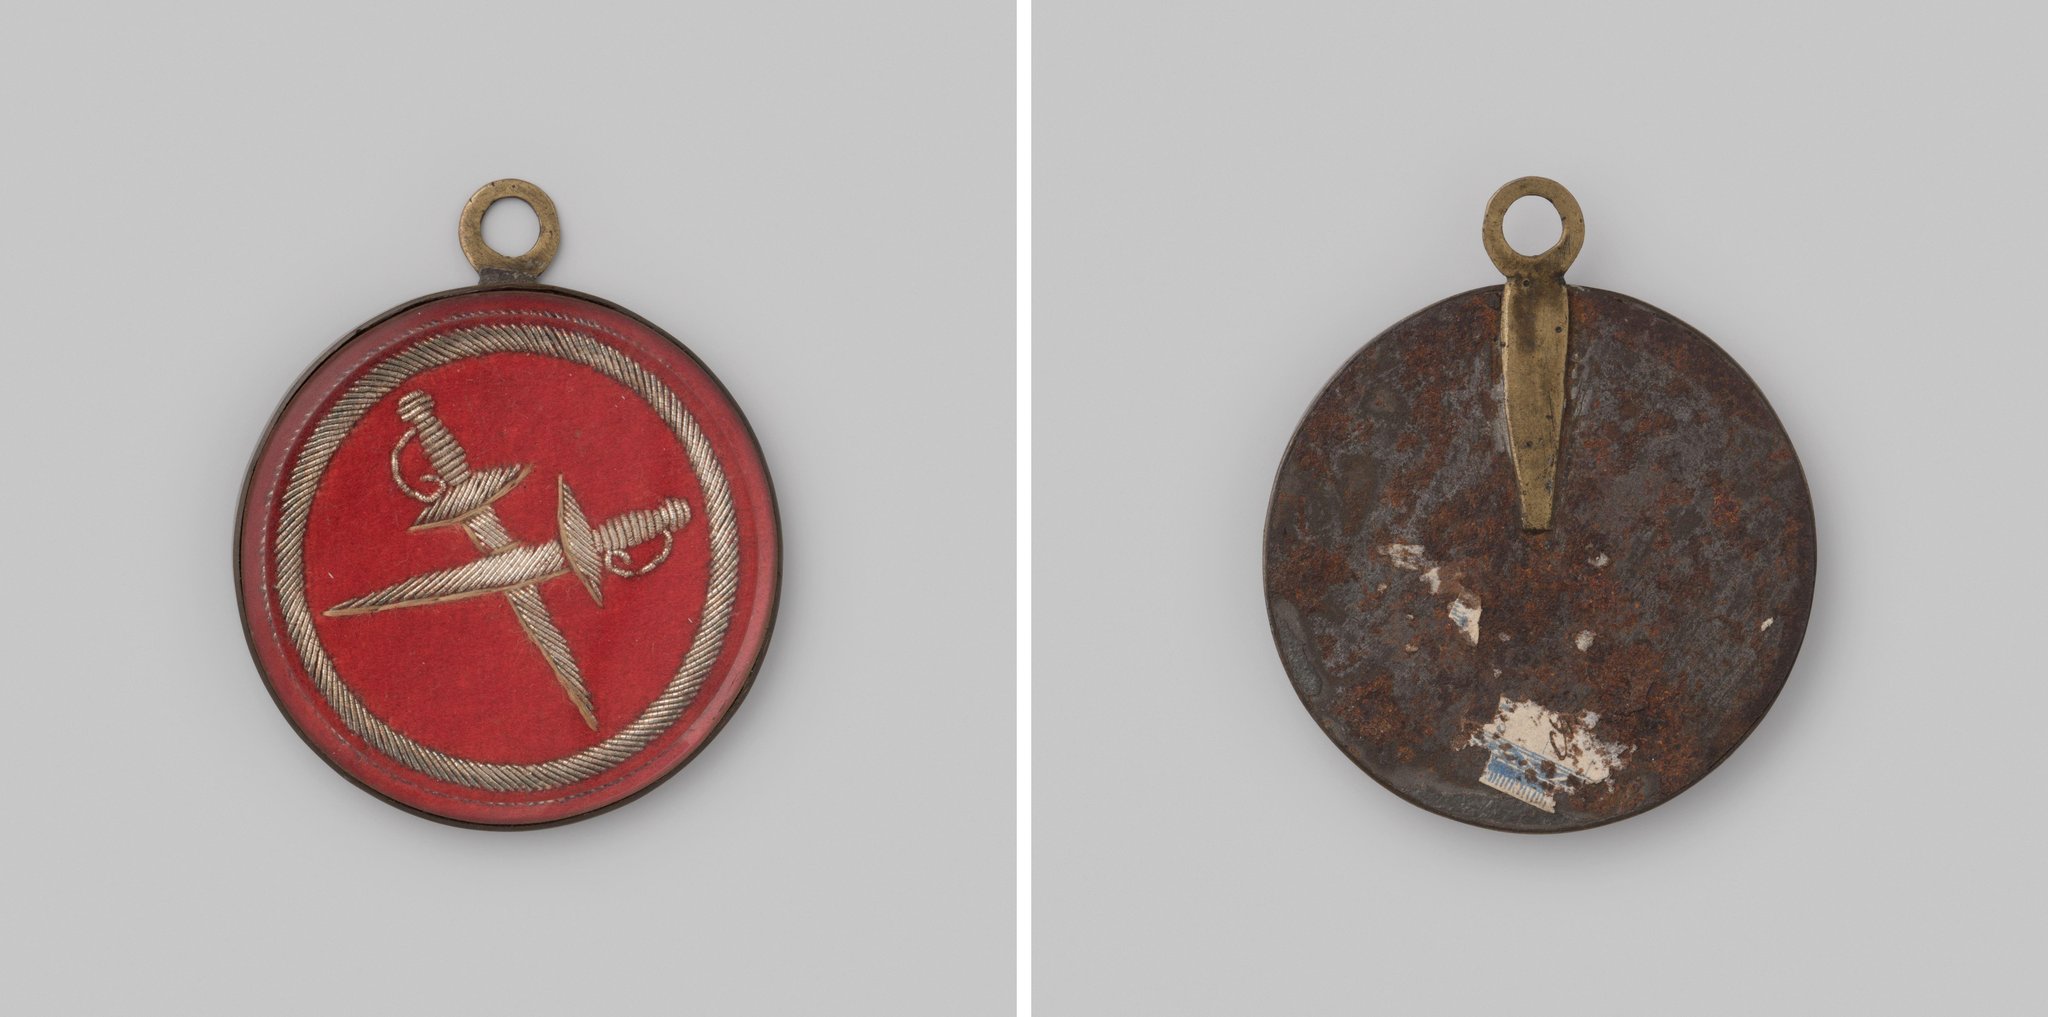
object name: insignia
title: Ereteken voor dertig jaar trouwe dienst voor ondergeschikten (1808)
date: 1808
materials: brass, glass, iron, thread, textile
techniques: embroidered, soldering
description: Rond medaillon van messing en ijzer met achter glas op rood laken een borduursel in zilverdraad van twee gekruiste zwaarden binnen een cirkel, met messing draagoog.